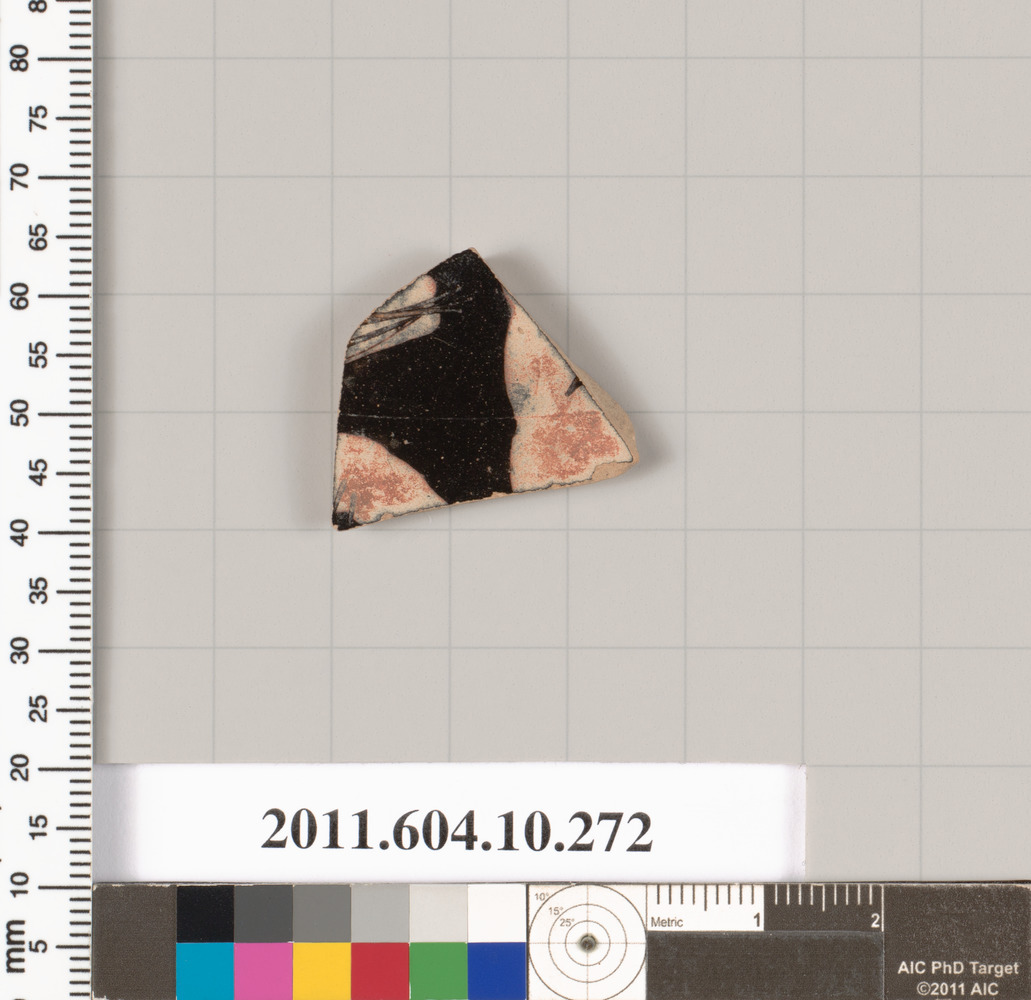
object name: unidentified open shape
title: Terracotta fragment of an open shape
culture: etruscan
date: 434-368 BCE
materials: terracotta